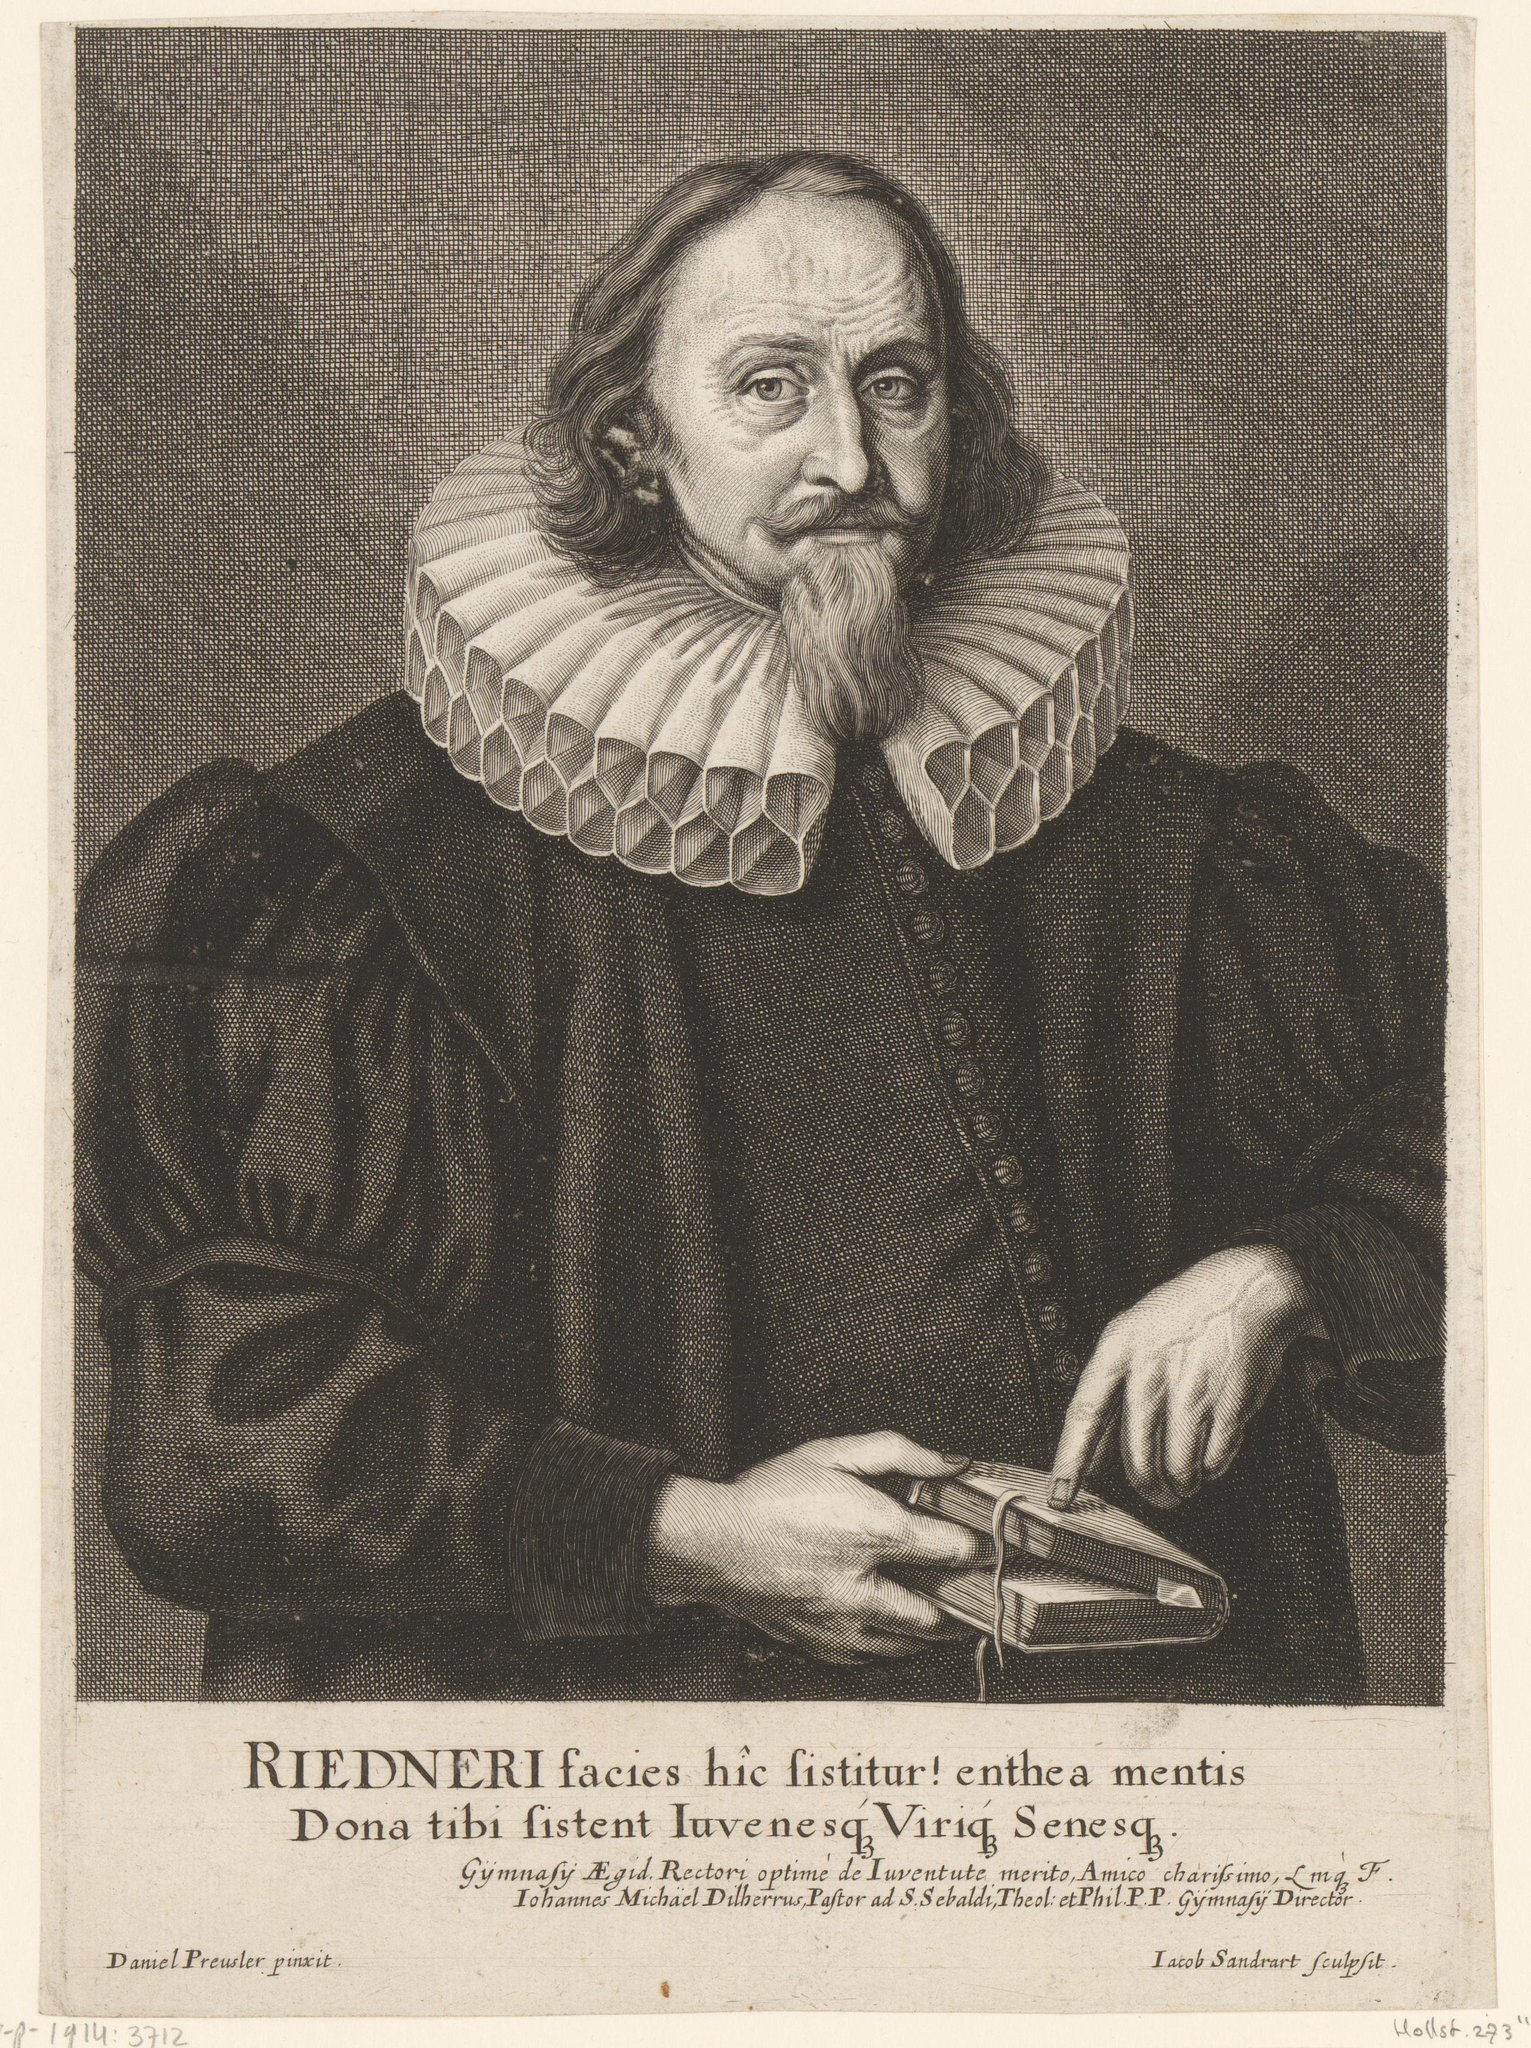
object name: print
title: Portret van Johann Riedner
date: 1656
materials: paper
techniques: engraving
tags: historical persons, book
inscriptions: collector's mark: Lugt 2228